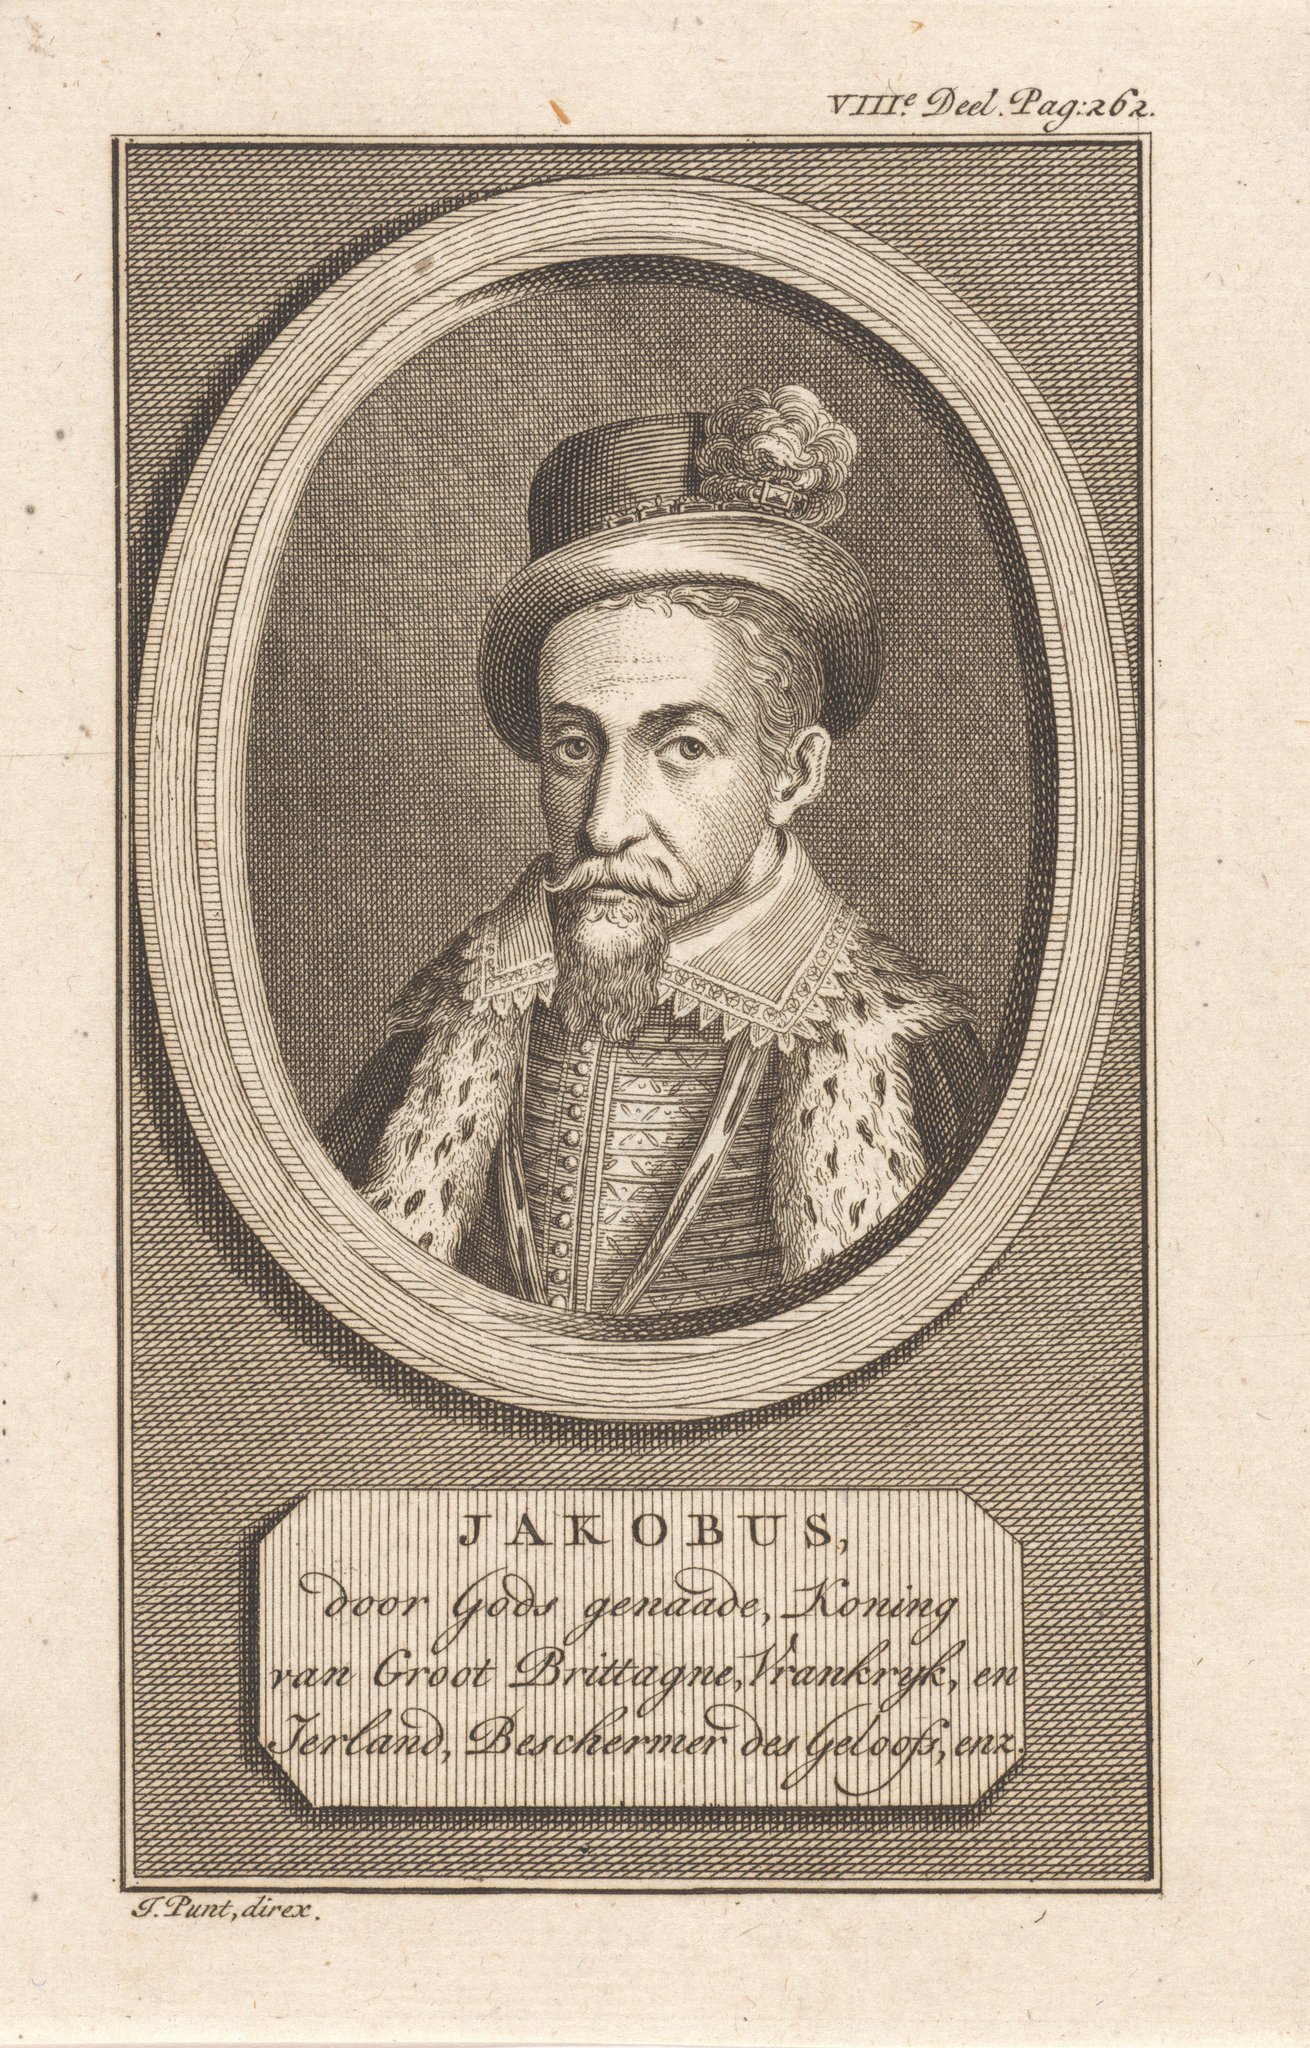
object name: print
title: Portret van Jacobus I, koning van Engeland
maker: jan punt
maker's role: draughtsman, print maker, publisher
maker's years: 1711-1779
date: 1760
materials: paper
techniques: engraving, etching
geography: northern netherlands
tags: jacobus i (koning van engeland)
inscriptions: collector's mark: Lugt 2228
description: Illustratie uit: Meteren, Emanuel van. Historie van de oorlogen en geschiedenissen der Nederlanderen, en der zelver naburen: beginnende met den jare 1315, en eindigende met den jare 1611, deel VIII, p. 262. Gorinchem: weduwe Nicolaas Goetzee, 1760.